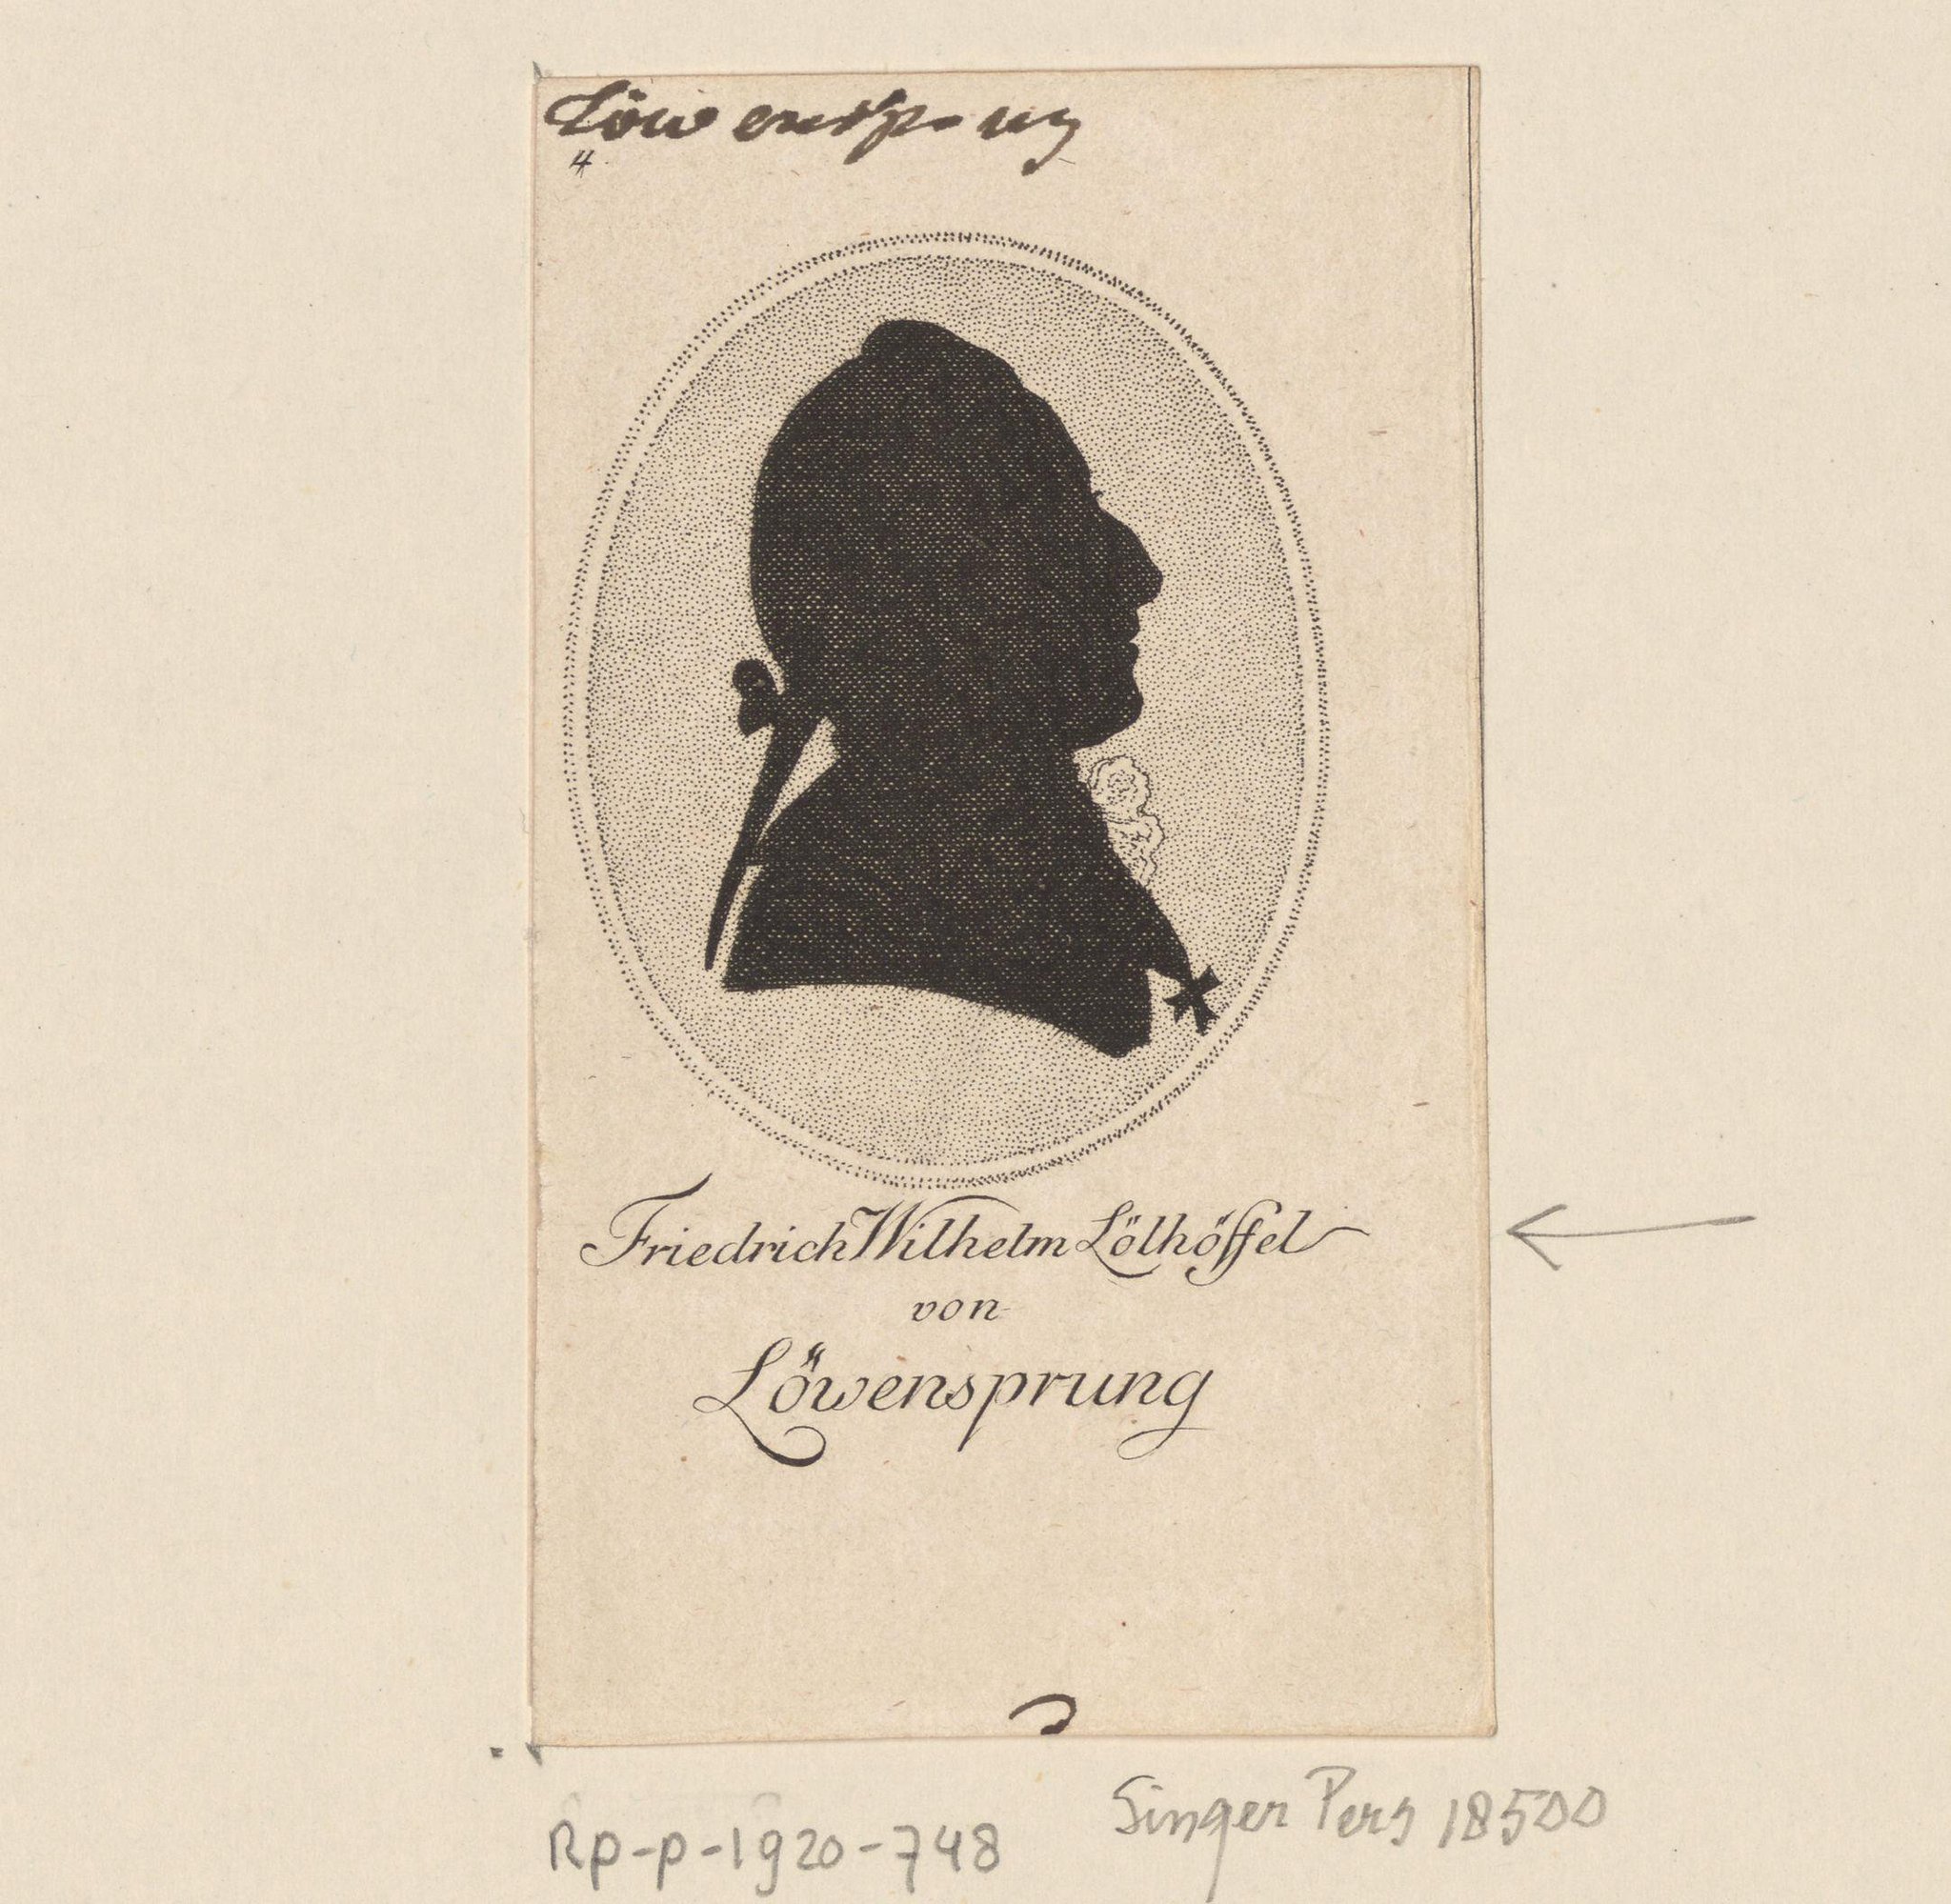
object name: print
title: Silhouetportret van Friedrich Wilhelm Lölhöffel von Löwensprung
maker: Anonymous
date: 1750-1799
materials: paper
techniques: engraving, etching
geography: germany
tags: historical persons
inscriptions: collector's mark: Lugt 2228, number: ‘1174’, inscription: ‘Löwensprung’